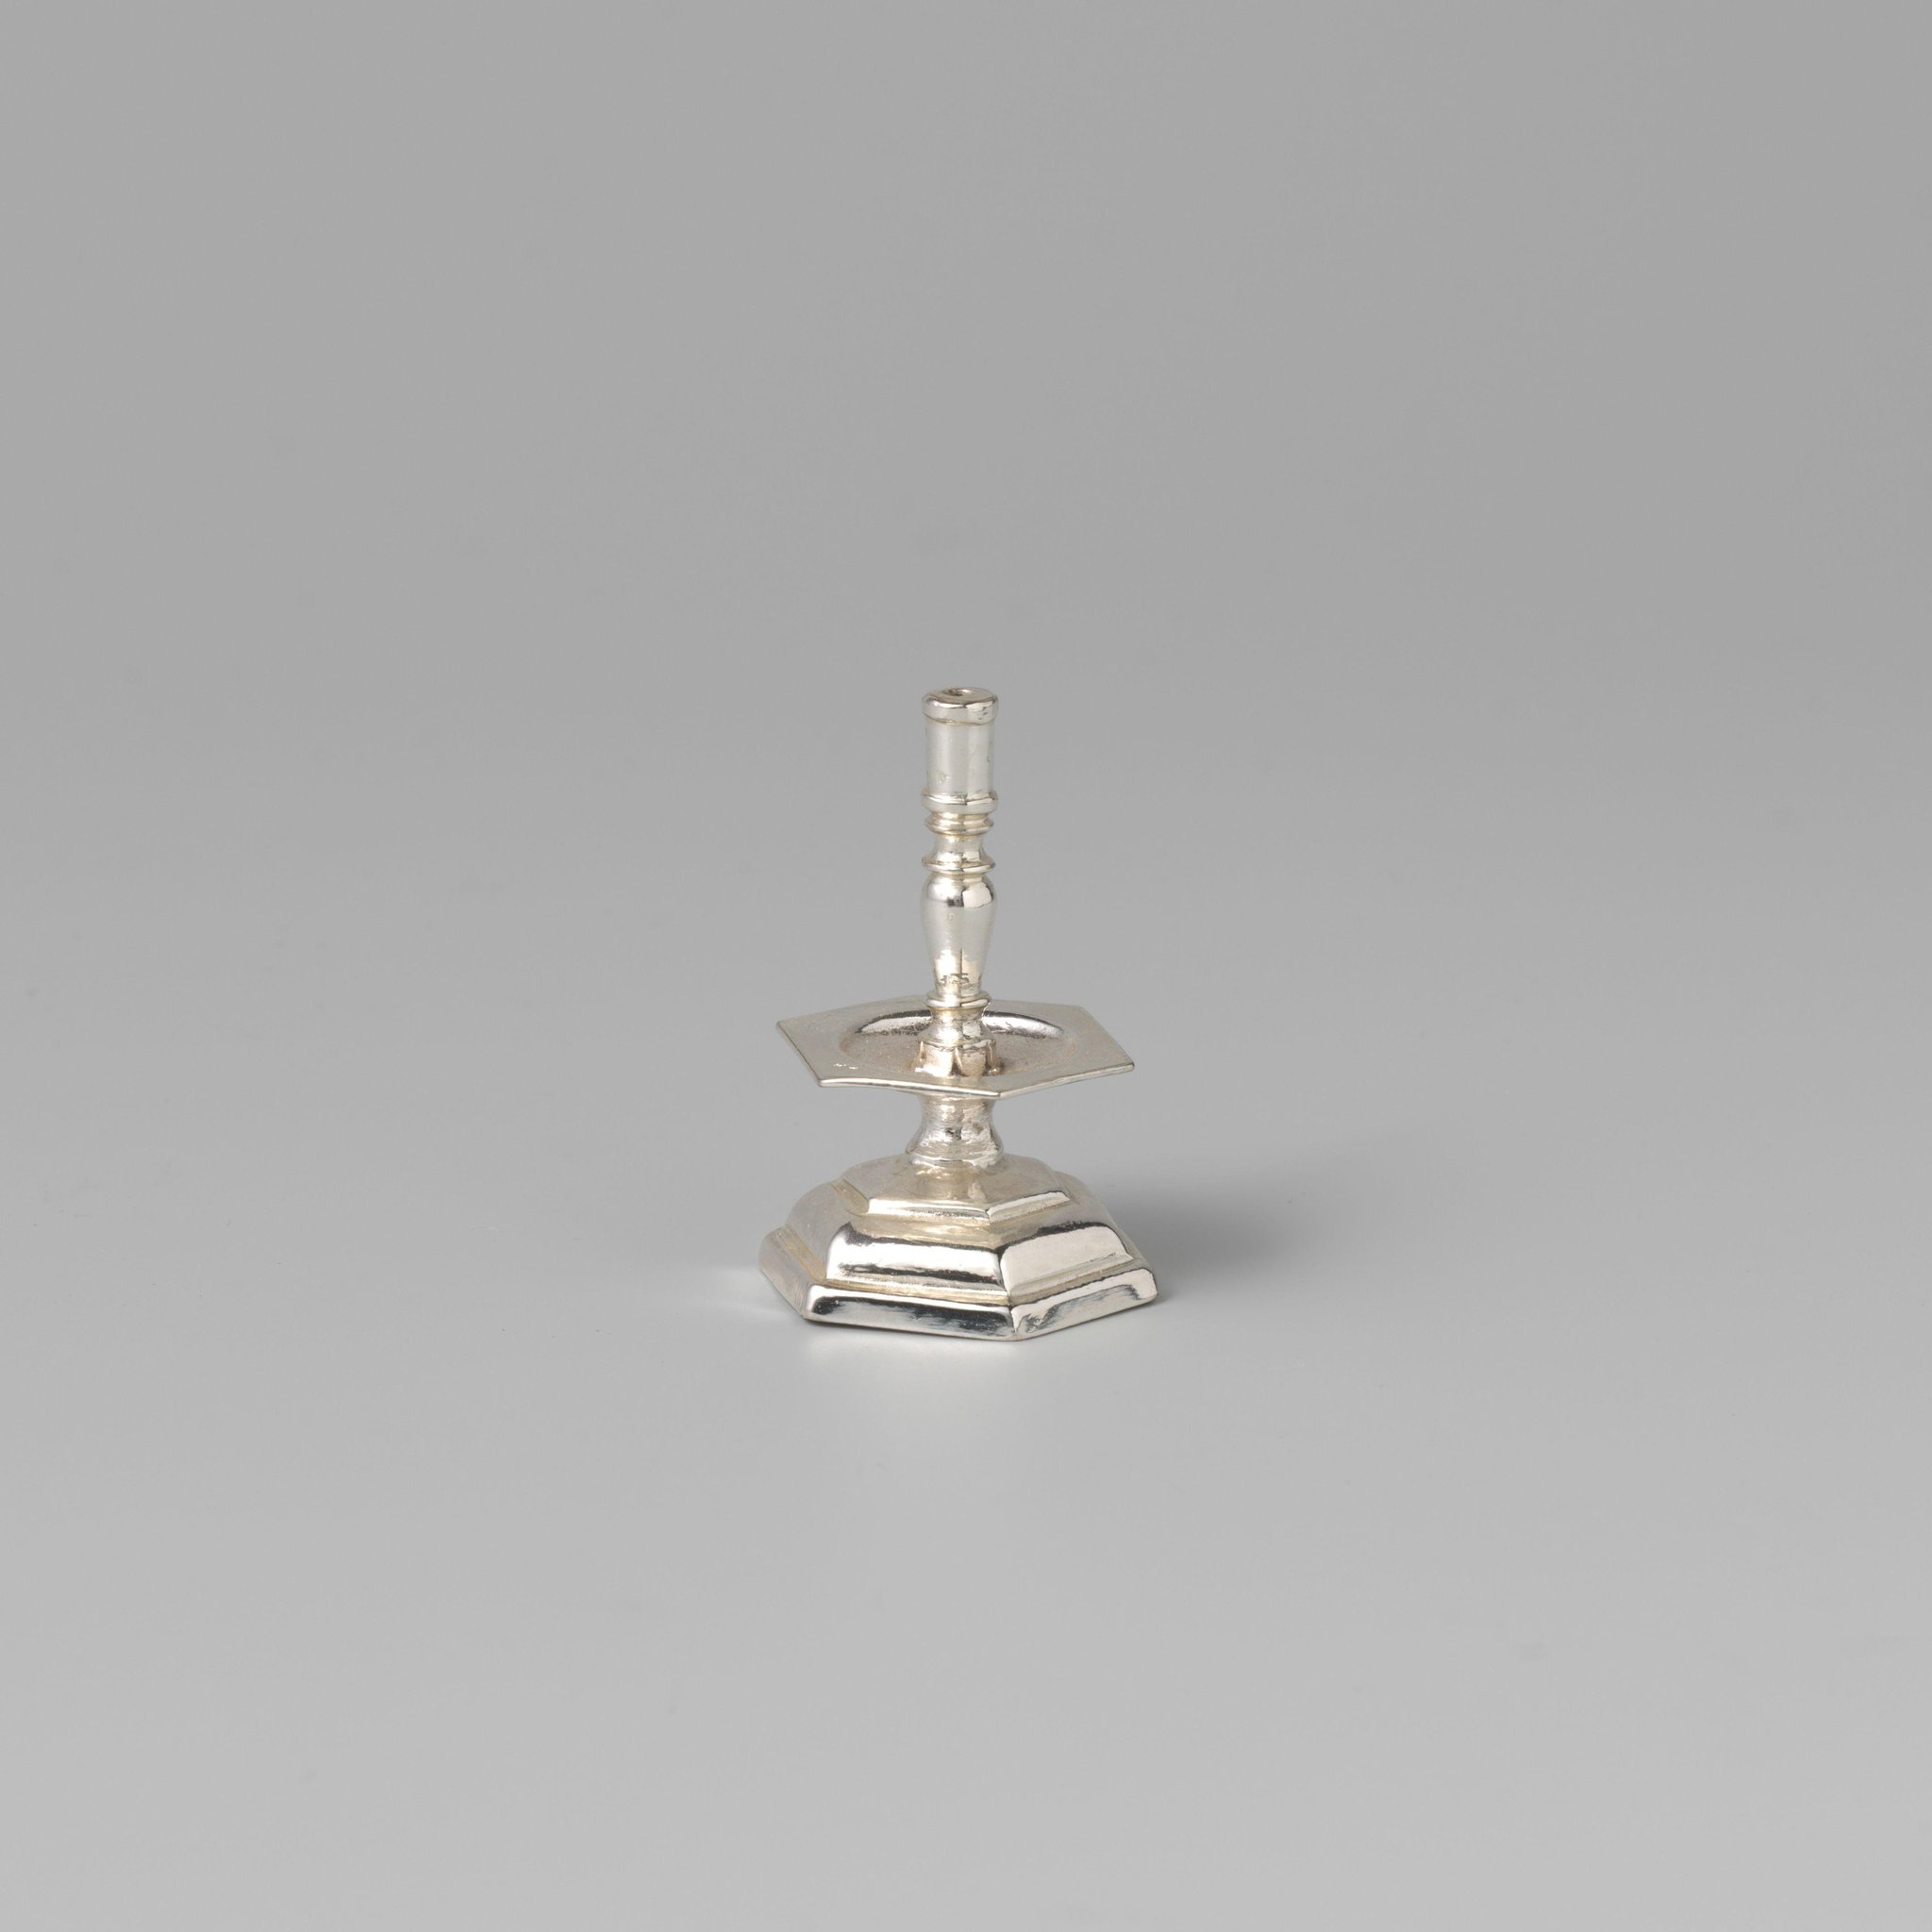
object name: miniature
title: Kandelaar van zilver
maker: boele rijnhout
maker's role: silversmith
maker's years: 1629-1689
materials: silver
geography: amsterdam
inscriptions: maker's mark: ‘lelie (Citroen 1975, nr. 1065)’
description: Kandelaar van zilver, gewelfde, zeshoekige voet, waarboven wijduitspringende vetvanger en balustervormige stam.